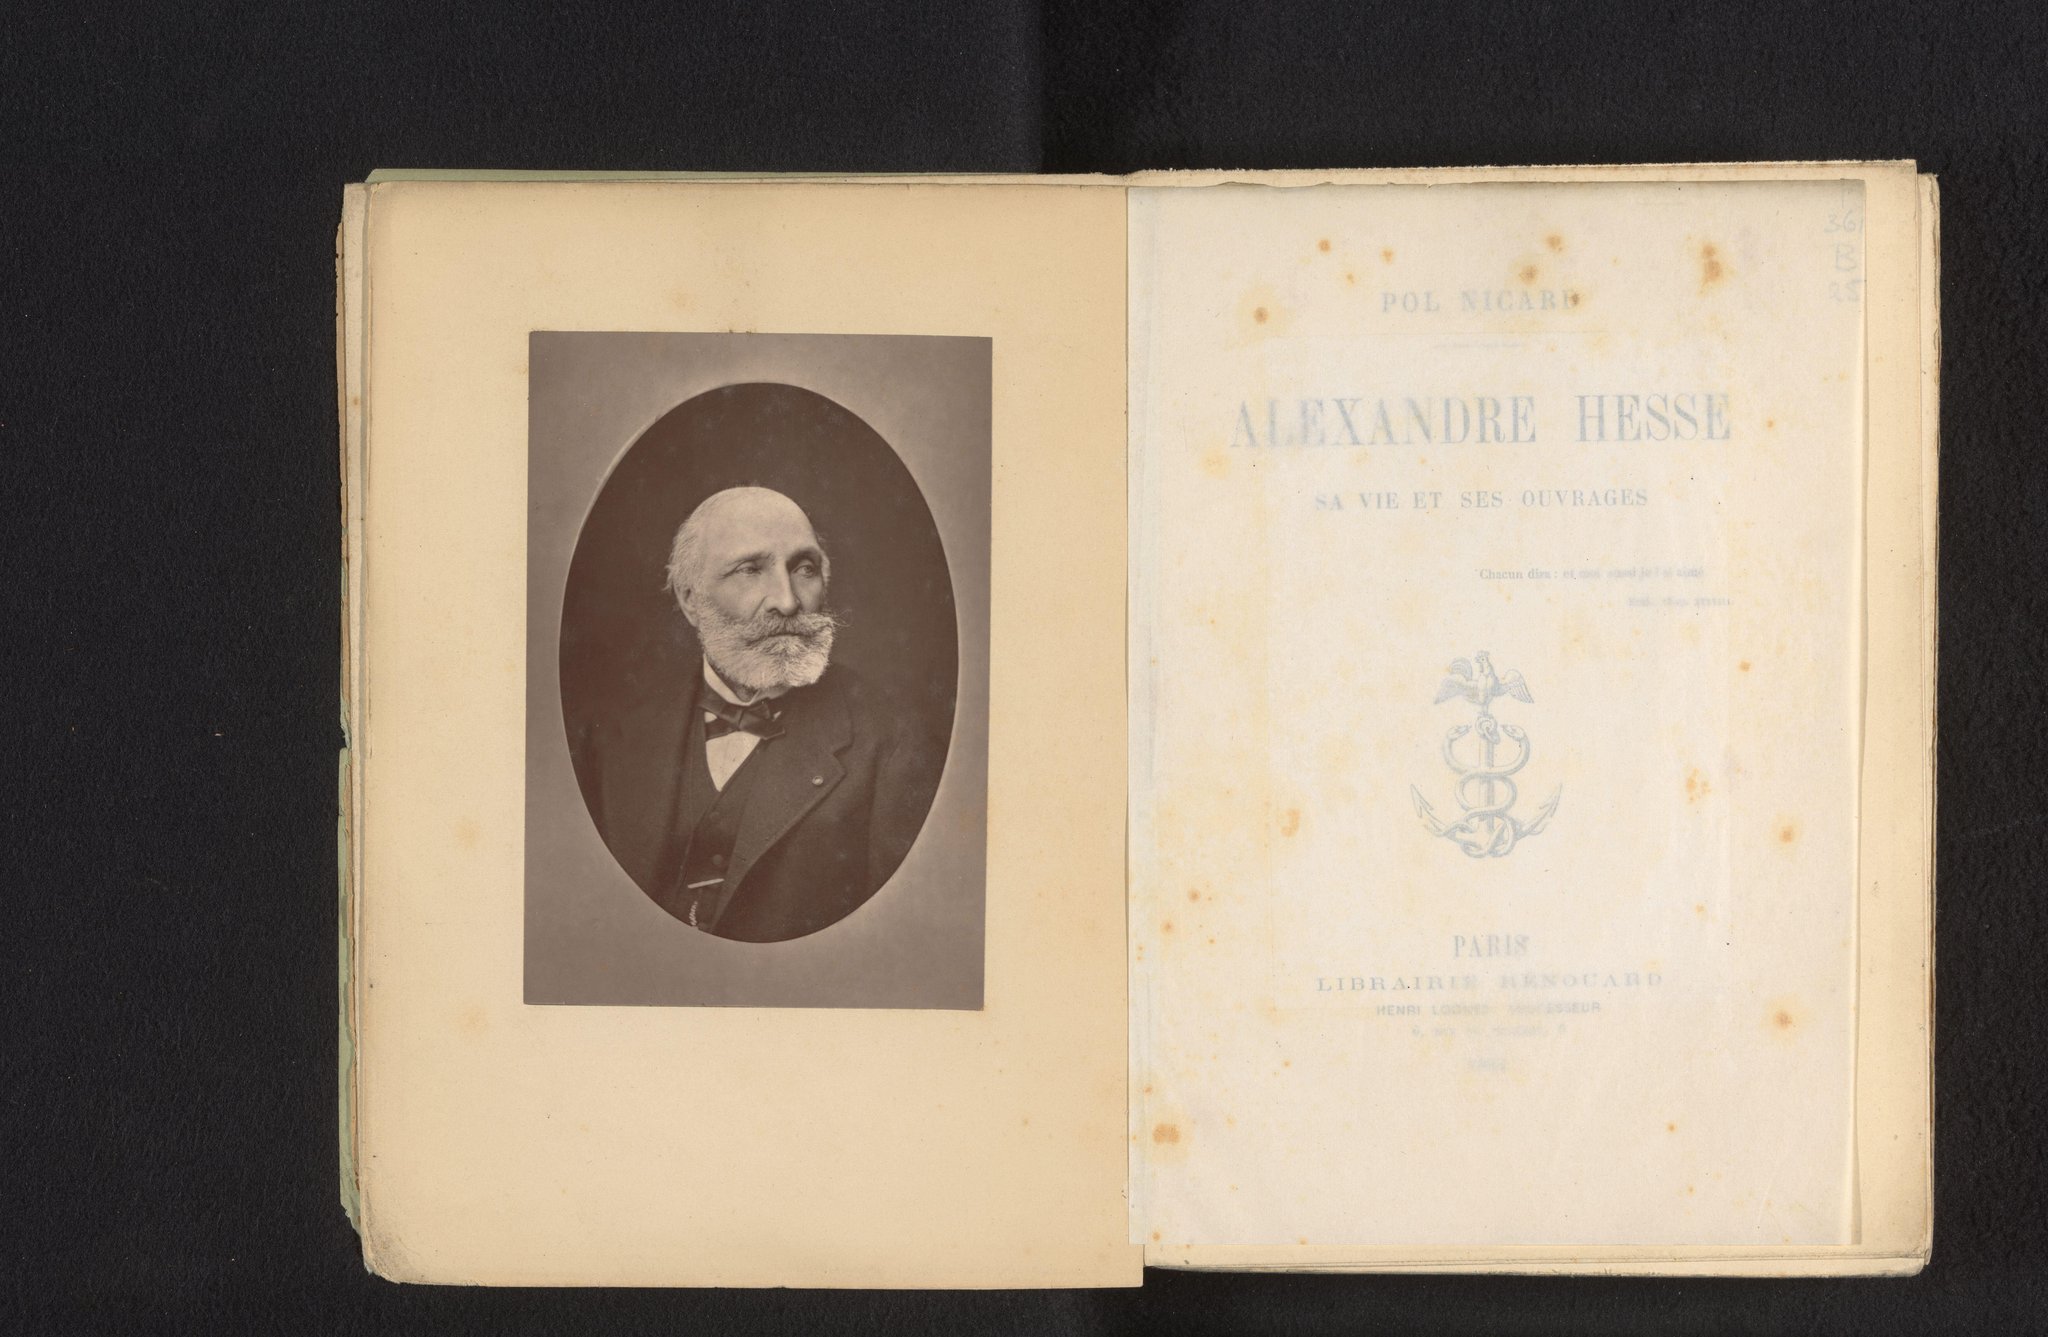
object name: page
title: Portret van Alexandre Hesse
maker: Anonymous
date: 1877-1882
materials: paper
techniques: woodburytype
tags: alexandre jean baptiste hesse, historical persons, portrait, self-portrait of painter